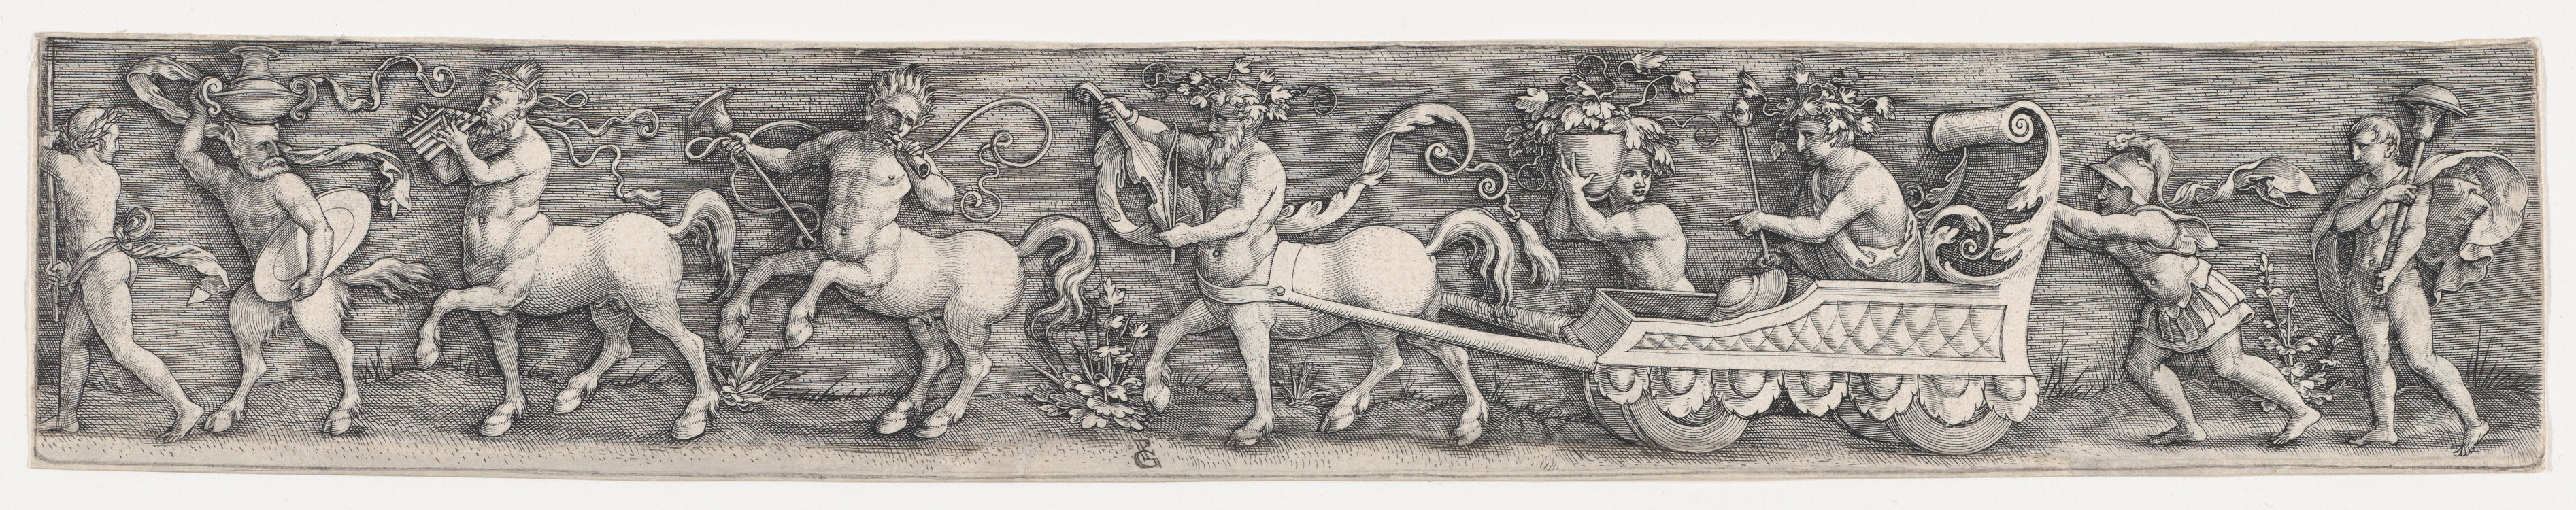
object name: print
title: The Triumph of Bacchus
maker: georg pencz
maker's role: artist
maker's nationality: german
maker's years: 1500-1550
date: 1534-1544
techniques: engraving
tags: musical instruments,centaurs,bacchus,satyrs,chariots